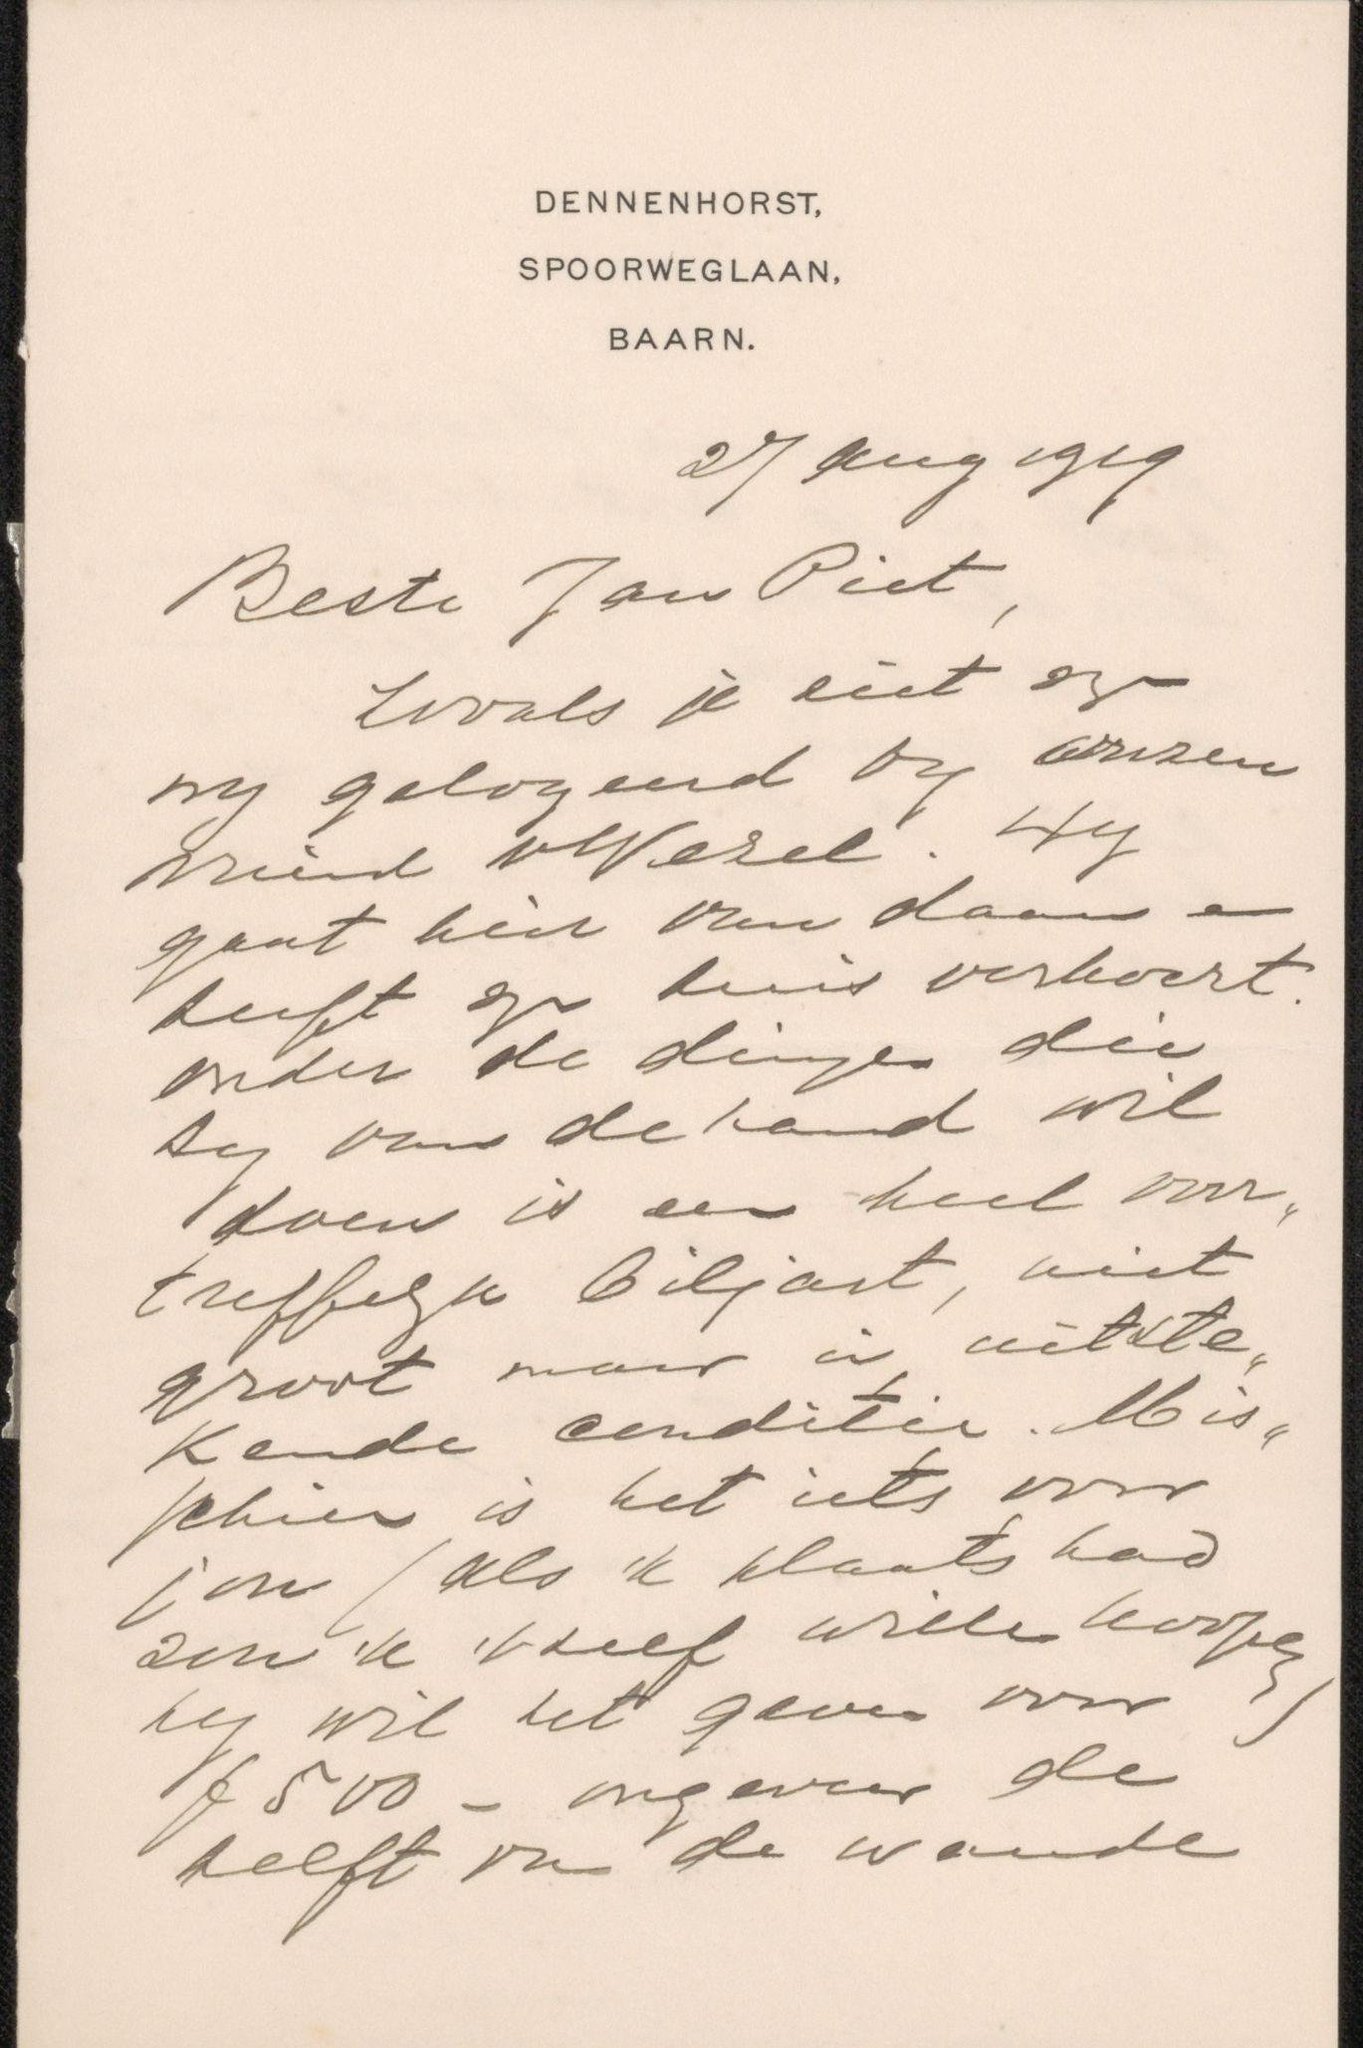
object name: letter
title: Brief aan Jan Veth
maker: willem witsen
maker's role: draughtsman, painter, print maker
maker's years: 1860-1923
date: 1919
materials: ink, paper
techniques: pen, printing, writing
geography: baarn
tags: dordrecht, designer, jan veth, the graphic arts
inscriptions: watermark, collector's mark: ‘RPK’